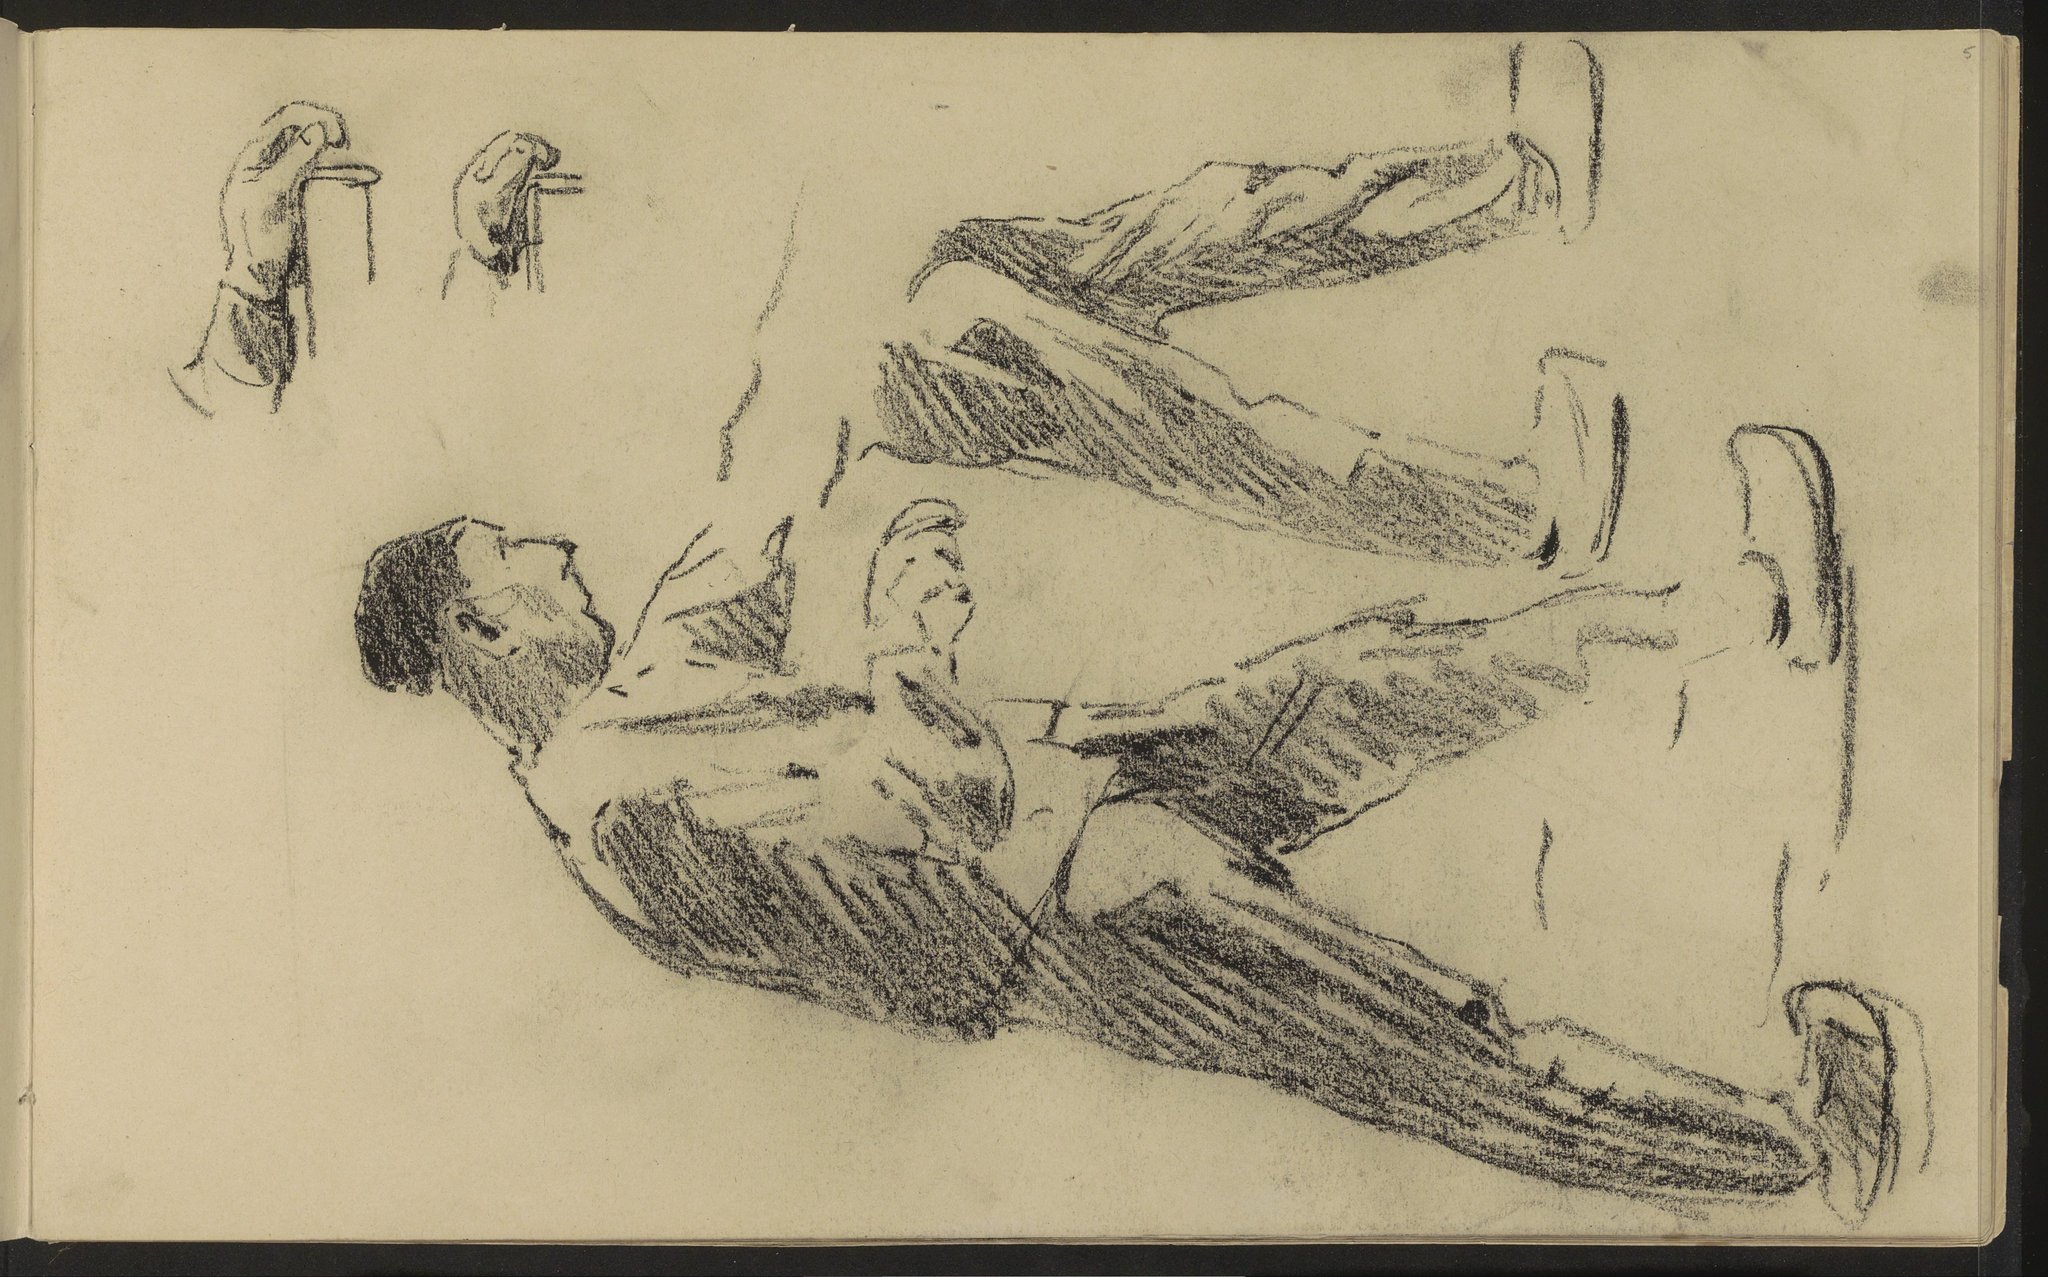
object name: sketchbook leaf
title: Dorpssmid aan het werk (Bram)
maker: willem witsen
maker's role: draughtsman, painter, print maker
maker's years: 1860-1923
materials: chalk, paper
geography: wijk bij duurstede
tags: smith, blacksmith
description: Voorstudie voor de ets 'Dorpssmid voor het raam (Bram)', ca. 1908.